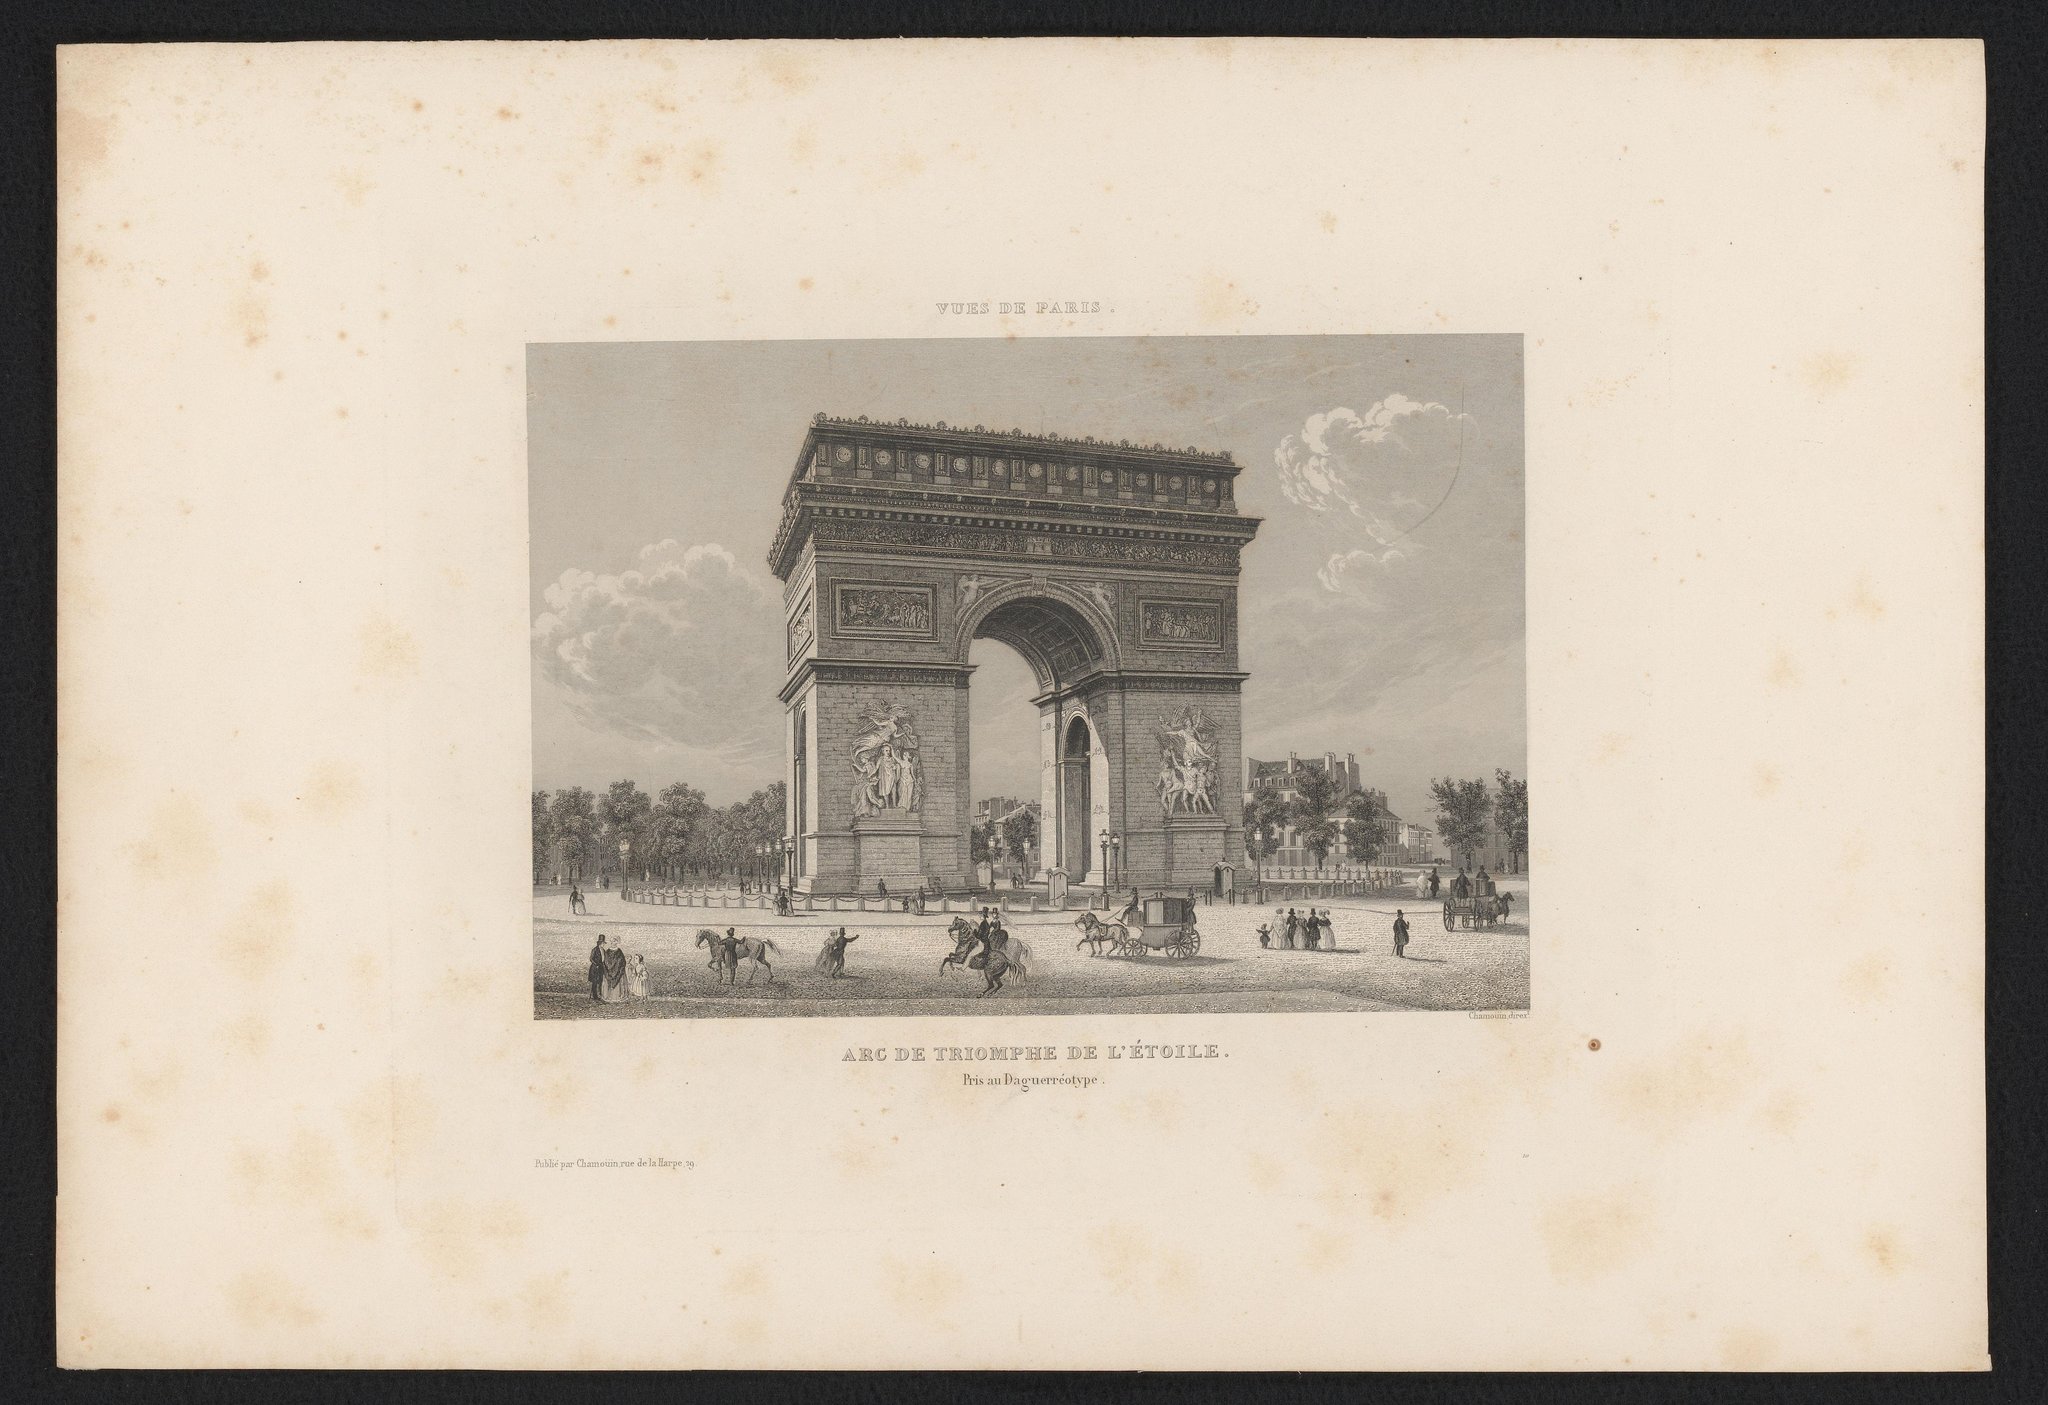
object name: print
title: Arc de Triomphe de l'Étoile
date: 1845-1850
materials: paper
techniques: engraving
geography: paris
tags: triumphal arch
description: Deze prent maakt deel uit van een omslag met 22 prenten op 22 bladen.